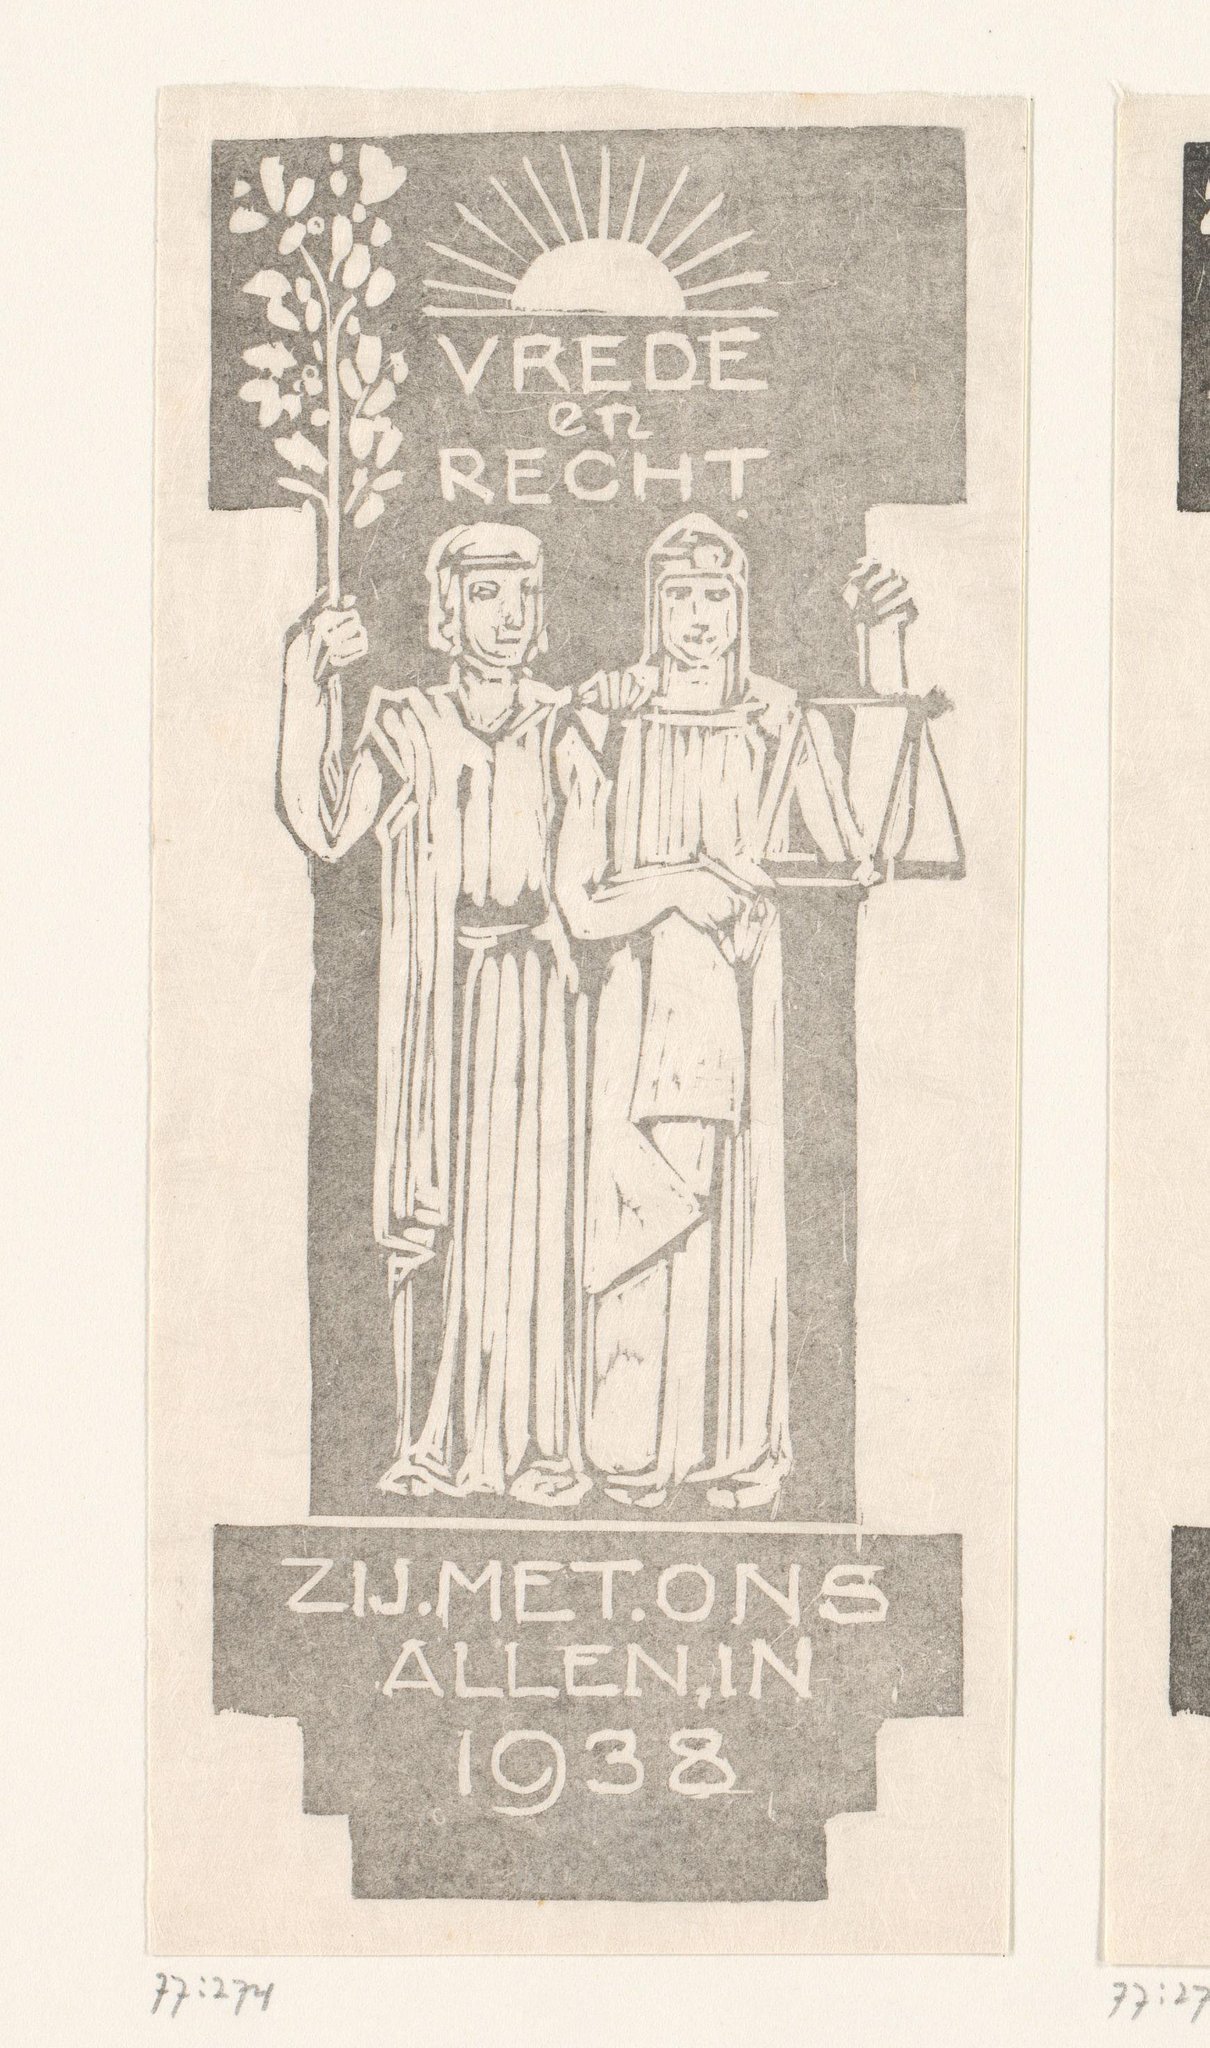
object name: print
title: Nieuwjaarswens voor het jaar 1938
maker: bernard willem wierink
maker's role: draughtsman, print maker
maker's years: 1856-1939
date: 1937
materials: paper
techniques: relief print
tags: symbols, allegories of peace, 'pax'; 'pace' (ripa), new year's eve (december 31), justice; 'forza alla giustitia sottoposta', 'giustitia', 'giustitia retta', 'giustitia rigorosa', 'impietà e violenza soggetta alla giustitia' (ripa)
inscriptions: collector's mark: Lugt 2228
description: Deze prent is waarschijnlijk een plaatsnede, ook al wordt in de literatuur veelal gesproken over een houtsnede. Voor zover Wierink zijn prenten in hoogdruk zelf heeft omschreven, heeft hij altijd de term 'plaatsnede' gebruikt.